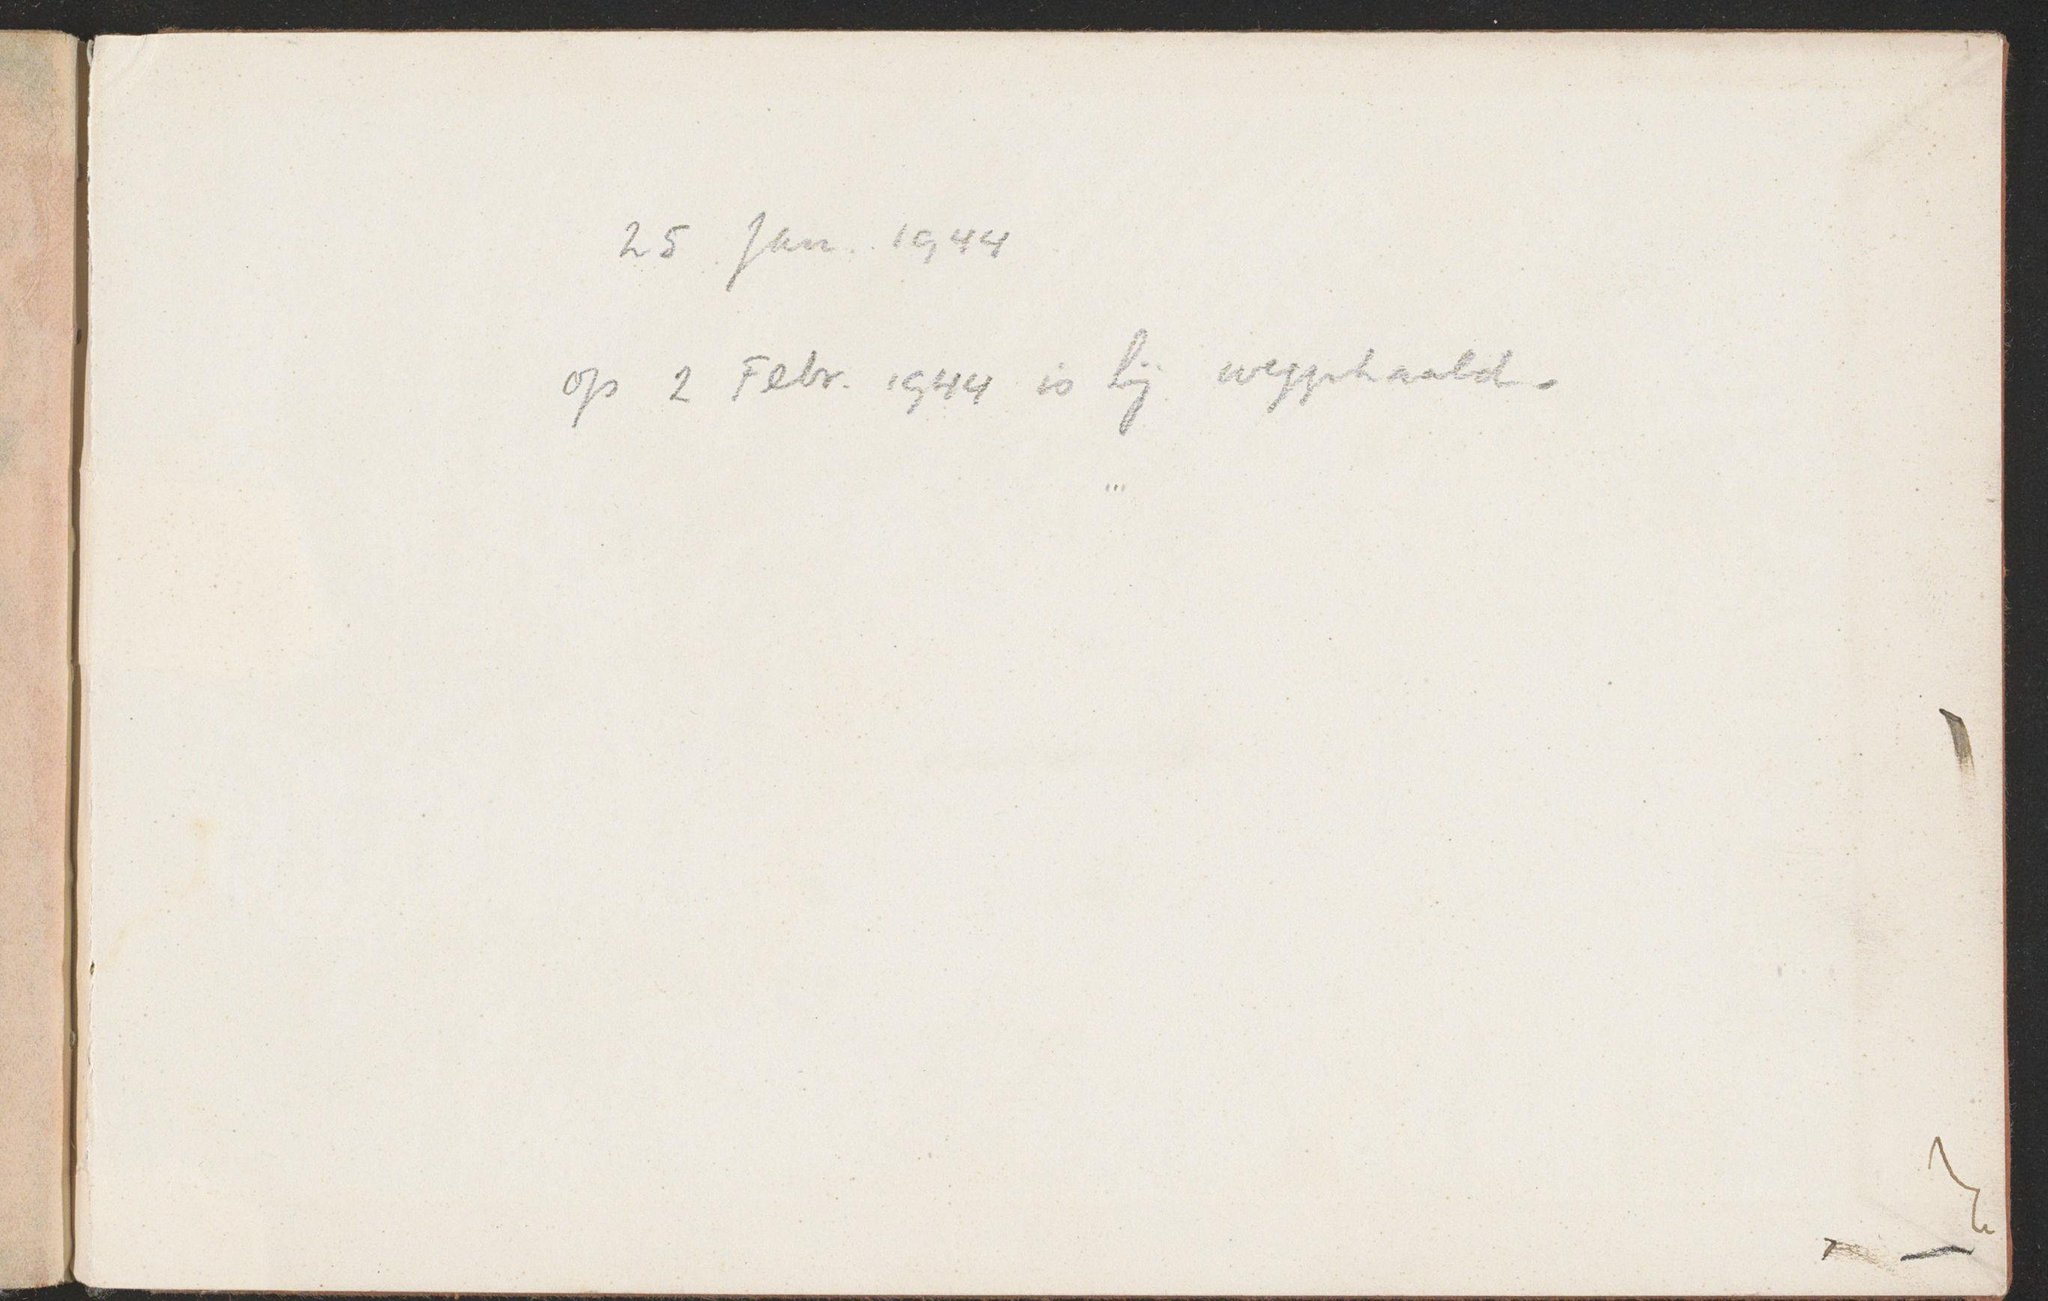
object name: sketchbook leaf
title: Notitie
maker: samuel jessurun de mesquita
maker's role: draughtsman, print maker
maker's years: 1868-1944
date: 1901-1944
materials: paper, pencil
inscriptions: annotation: ‘25 Jan. 1944/ op 2 februari 1944 is hij weggehaald.’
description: Achterste schutblad uit een schetsboek met 18 bladen.